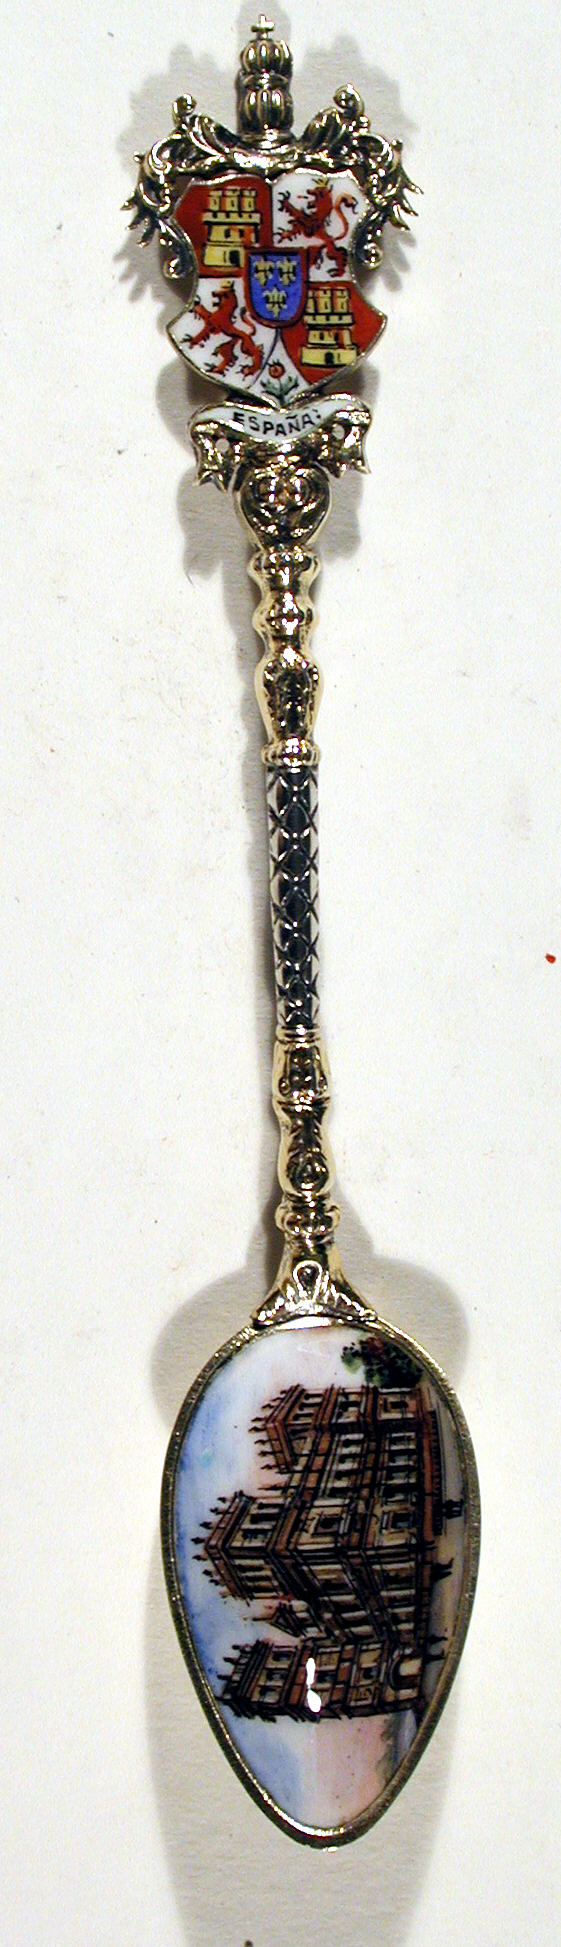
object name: souvenir spoon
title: Souvenir spoon with view of Palais Royal and arms of Spain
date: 1867-1900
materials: enamel, gilt, silver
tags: palaces,coat of arms